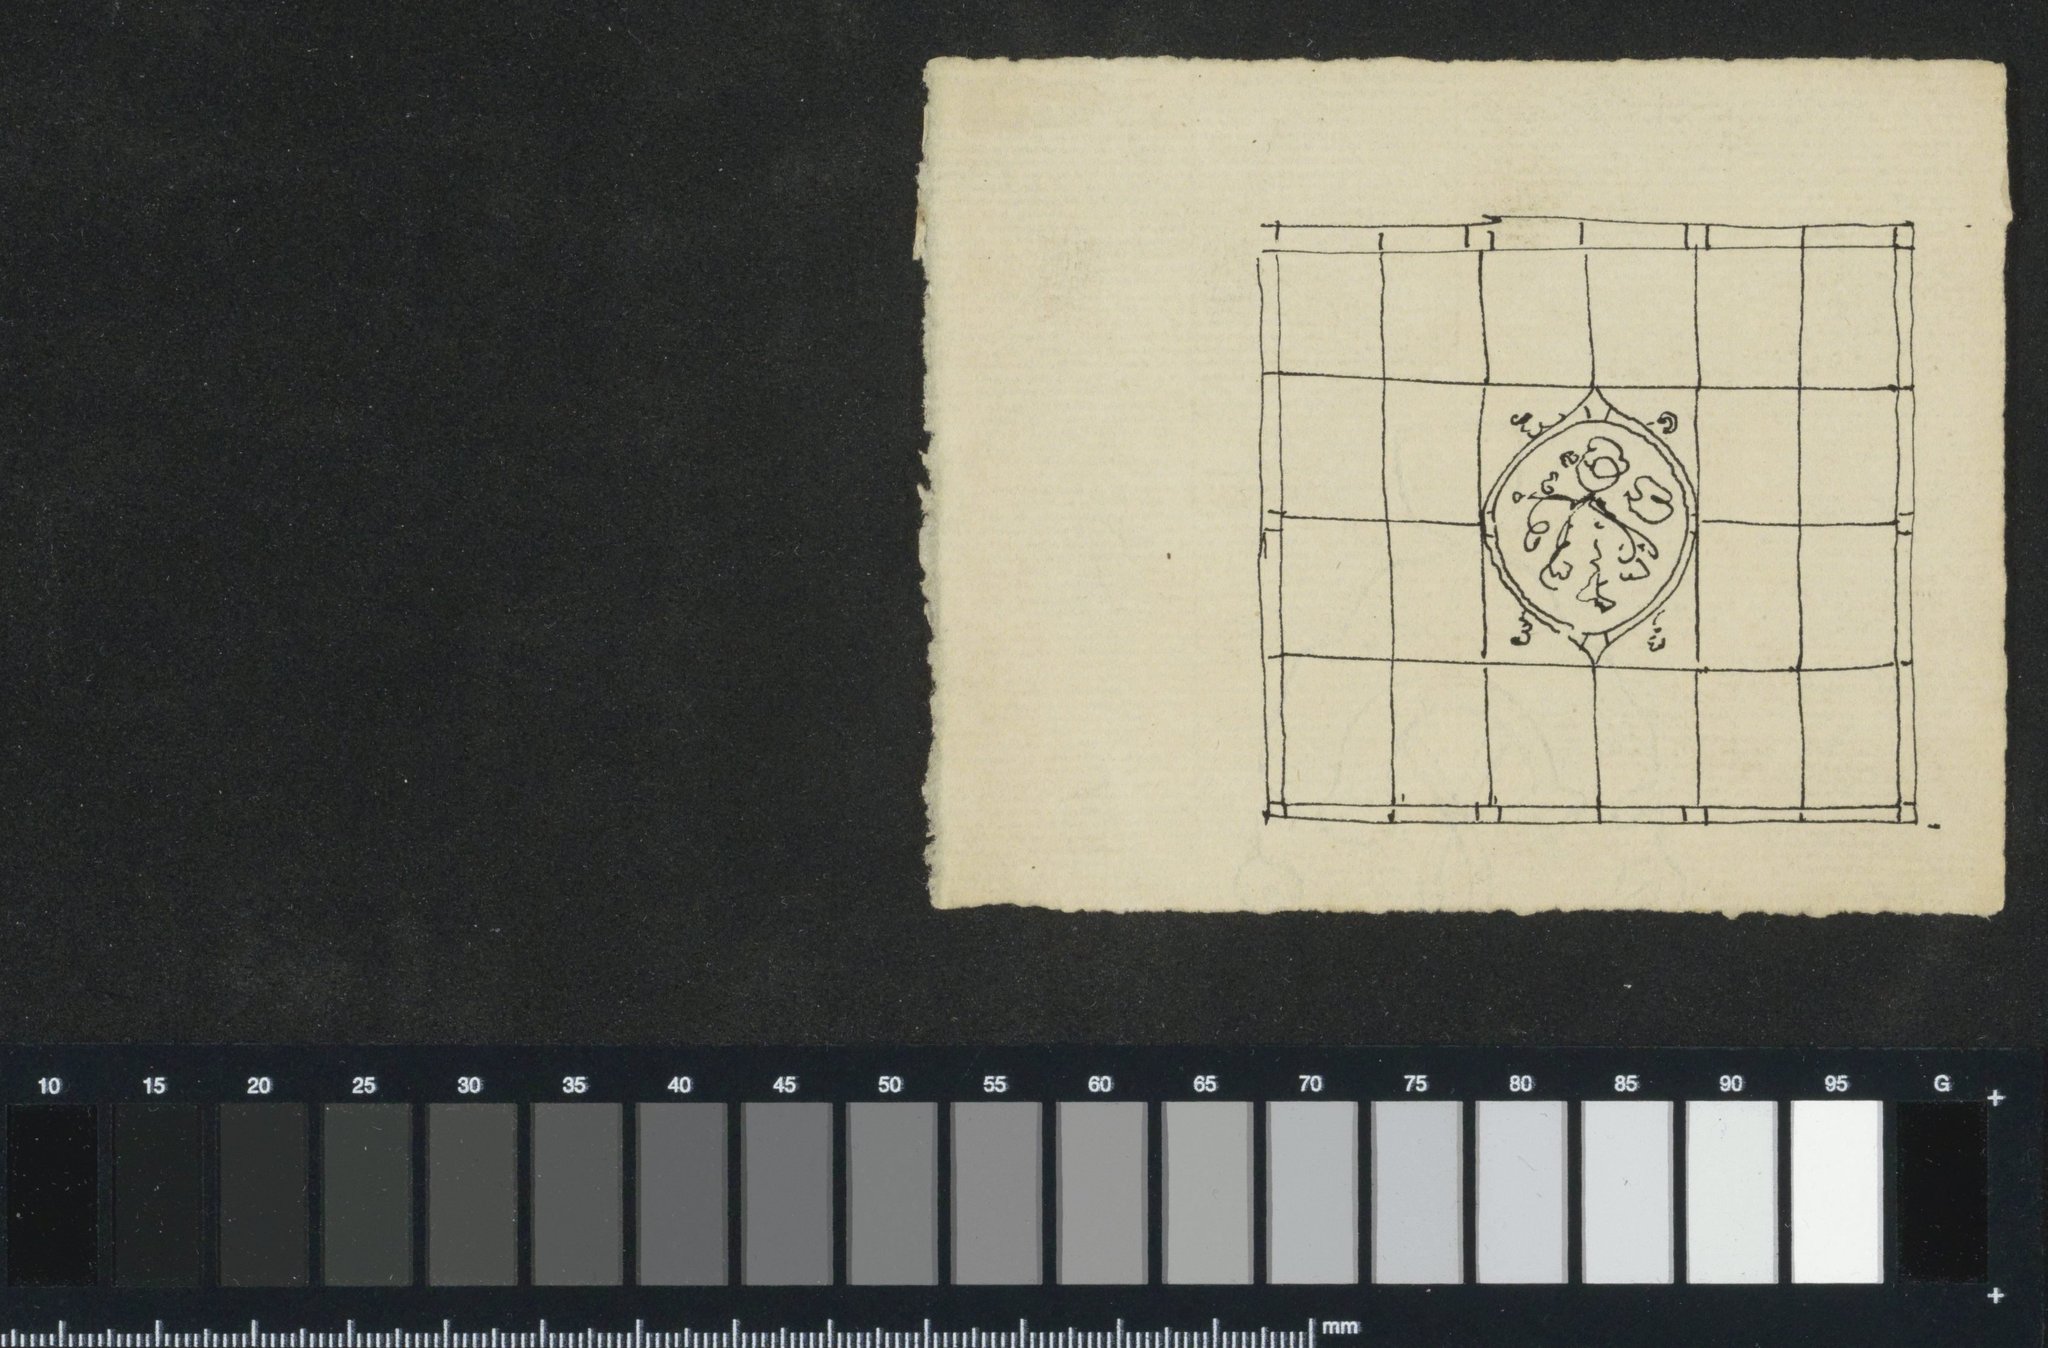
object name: drawing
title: Ontwerp voor een glas-in-loodvenster met medaillon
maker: gerrit willem dijsselhof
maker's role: designer, draughtsman, print maker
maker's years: 1866-1924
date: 1876-1924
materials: ink, paper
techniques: pen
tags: window, work of applied art